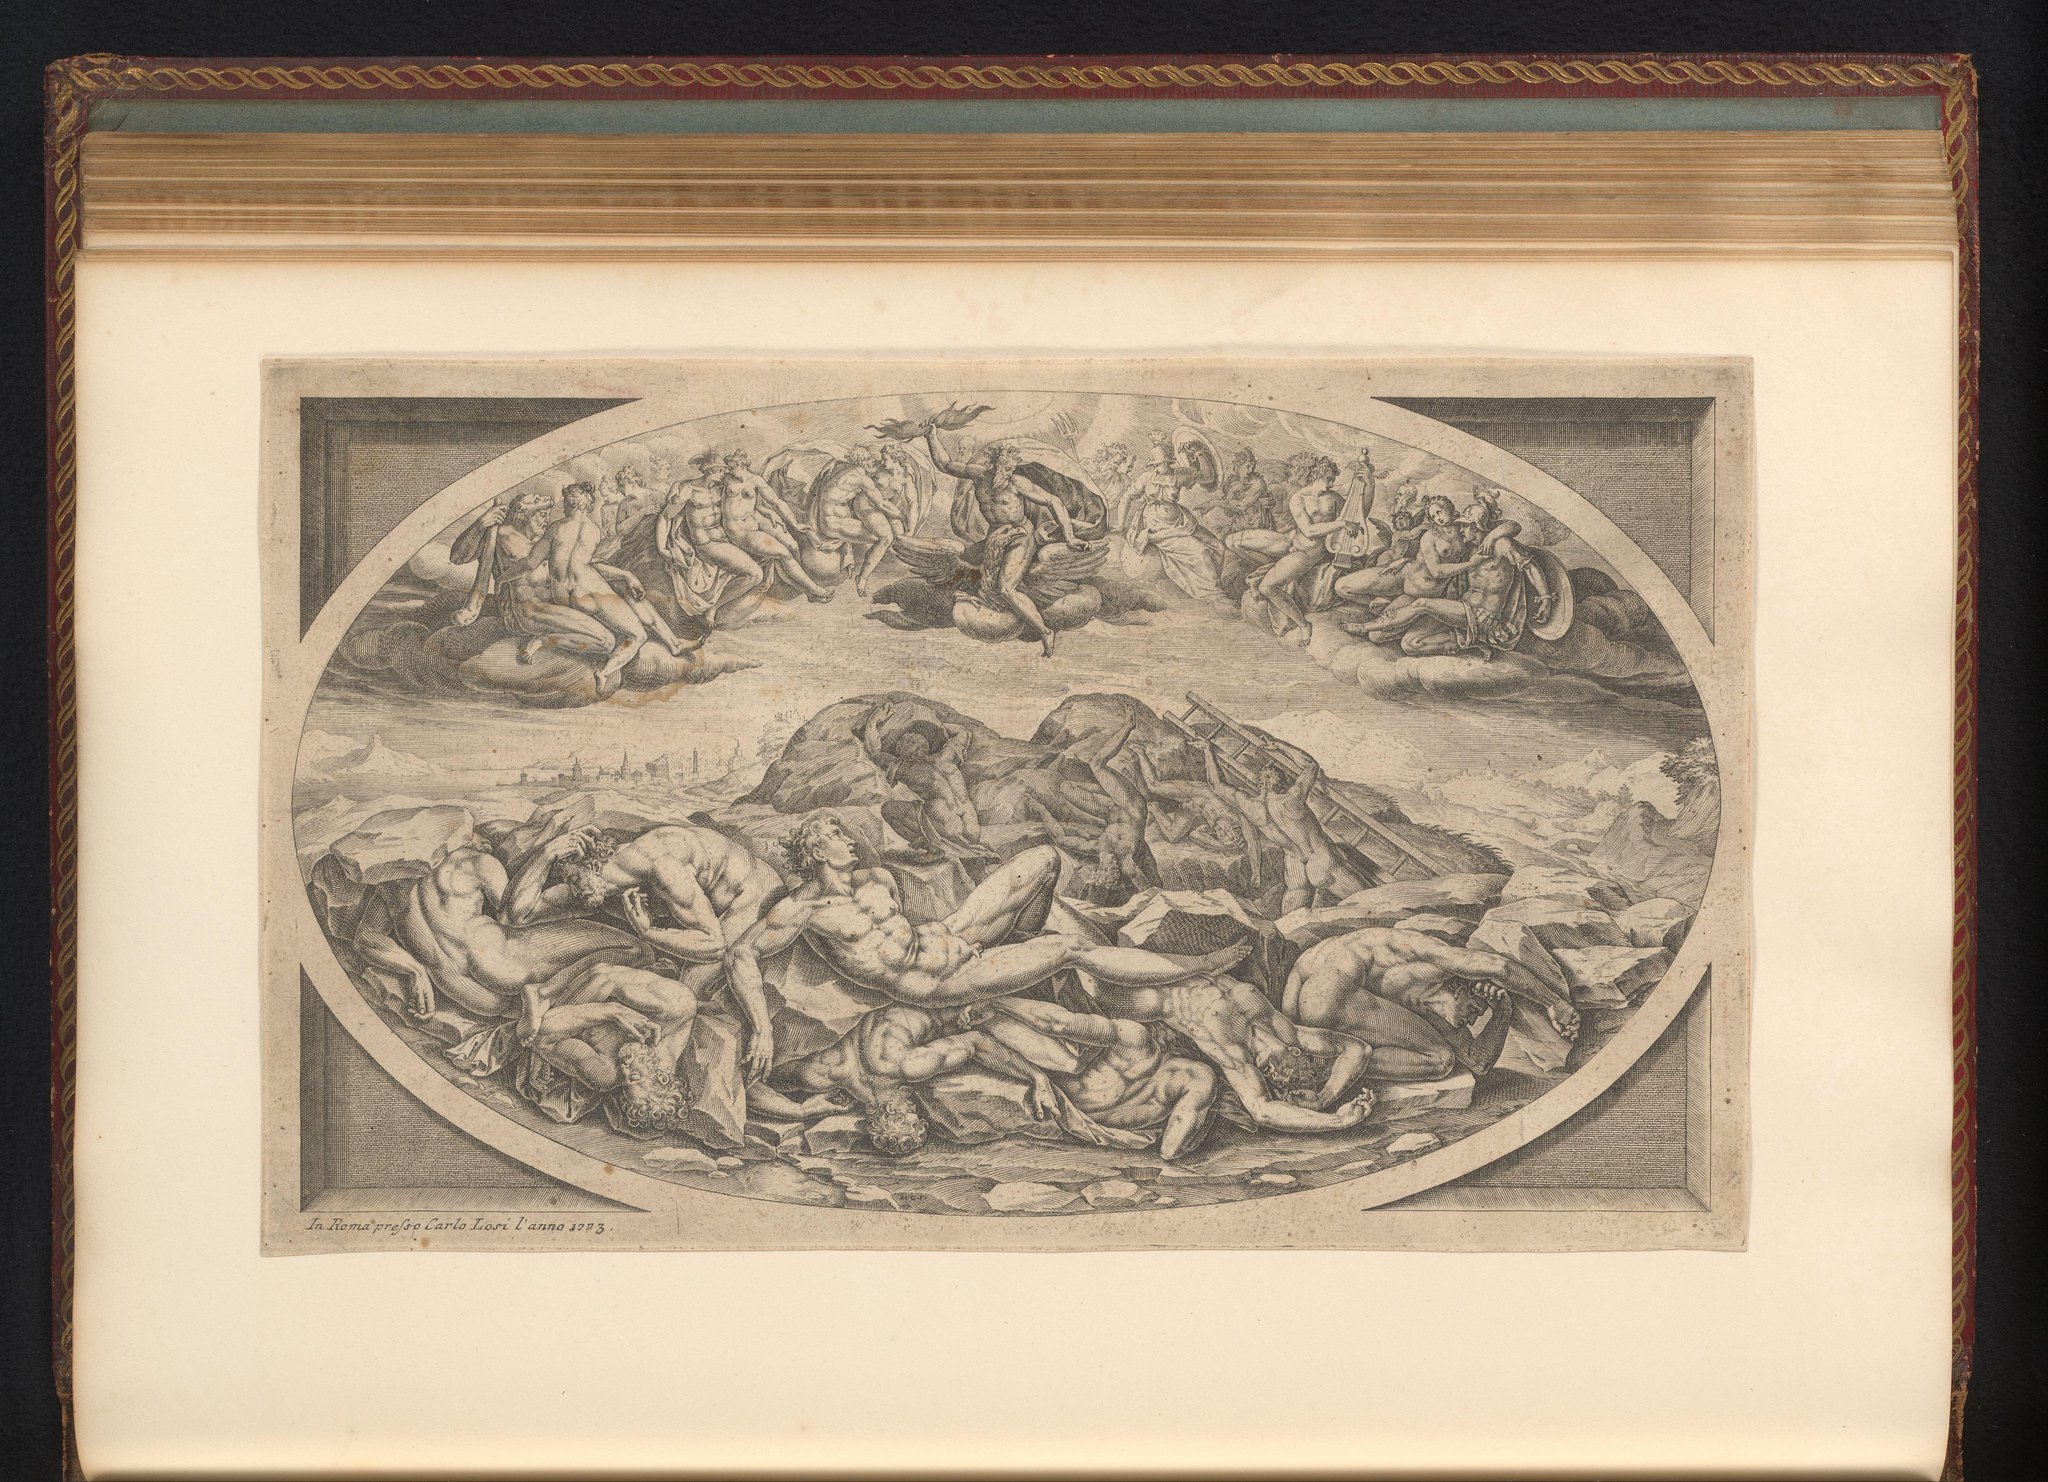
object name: print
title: Val van de giganten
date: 1773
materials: paper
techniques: engraving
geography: rome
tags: the giants buried beneath volcanoes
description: De samensteller heeft deze prent in het album geplakt als illustratie bij: Pilkington, Matthew en Johann Heinrich Füssli. A dictionary of painters, from the revival of the art to the present period. 4 dln. Londen: John Crowder, 1805, dl. 2, p. 290.